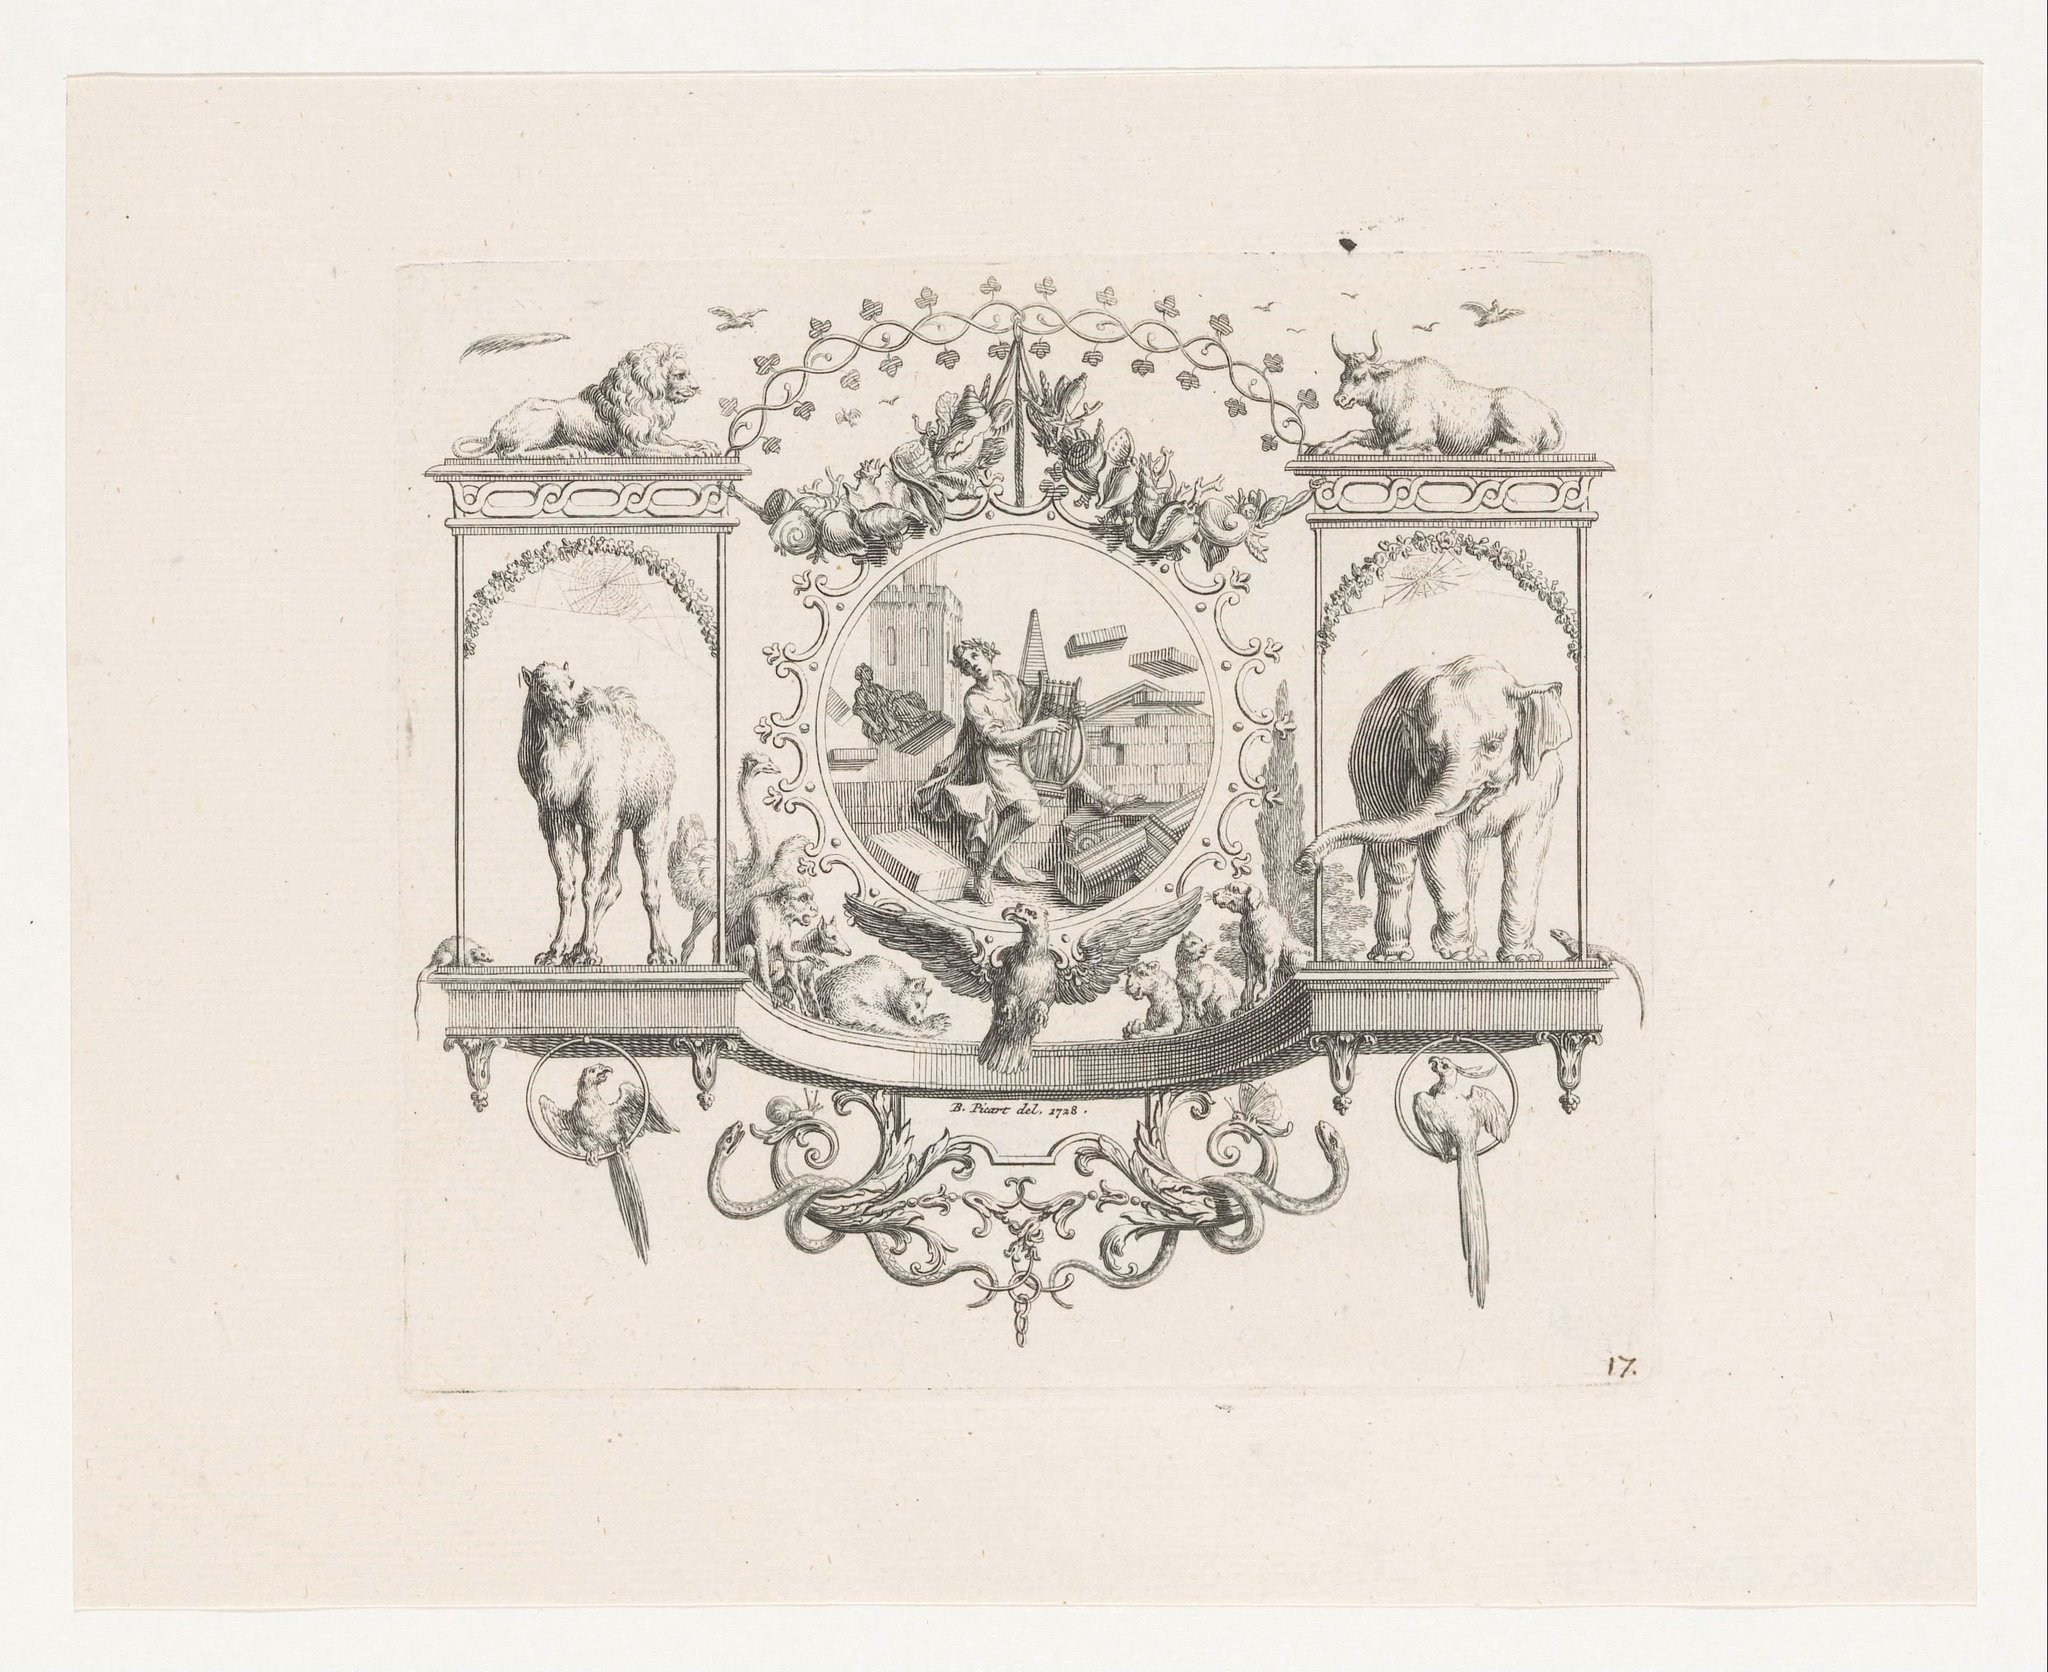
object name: ornament print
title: Amphion bespeelt de lier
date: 1728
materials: paper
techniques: engraving, etching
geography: amsterdam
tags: paris, nicolas boileau, hoofed animals: camel, ornaments ~ art, amphion building the walls of thebes (without zethus), trunked animals: elephant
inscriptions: collector's mark: Lugt 2228, number: ‘17.’, inscription: ‘[A]P 305’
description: Prent mogelijk gebruikt in: Boileau-Despréaux, Nicolas. Oeuvres. Amsterdam: François Changuion, Den Haag, Pieter de Hondt, 1729. Nummer 7 in: Explication des Vignettes de la Seconde Edition des Oeuvres de Boileau. Amsterdam: Bernard Picart, 1729.